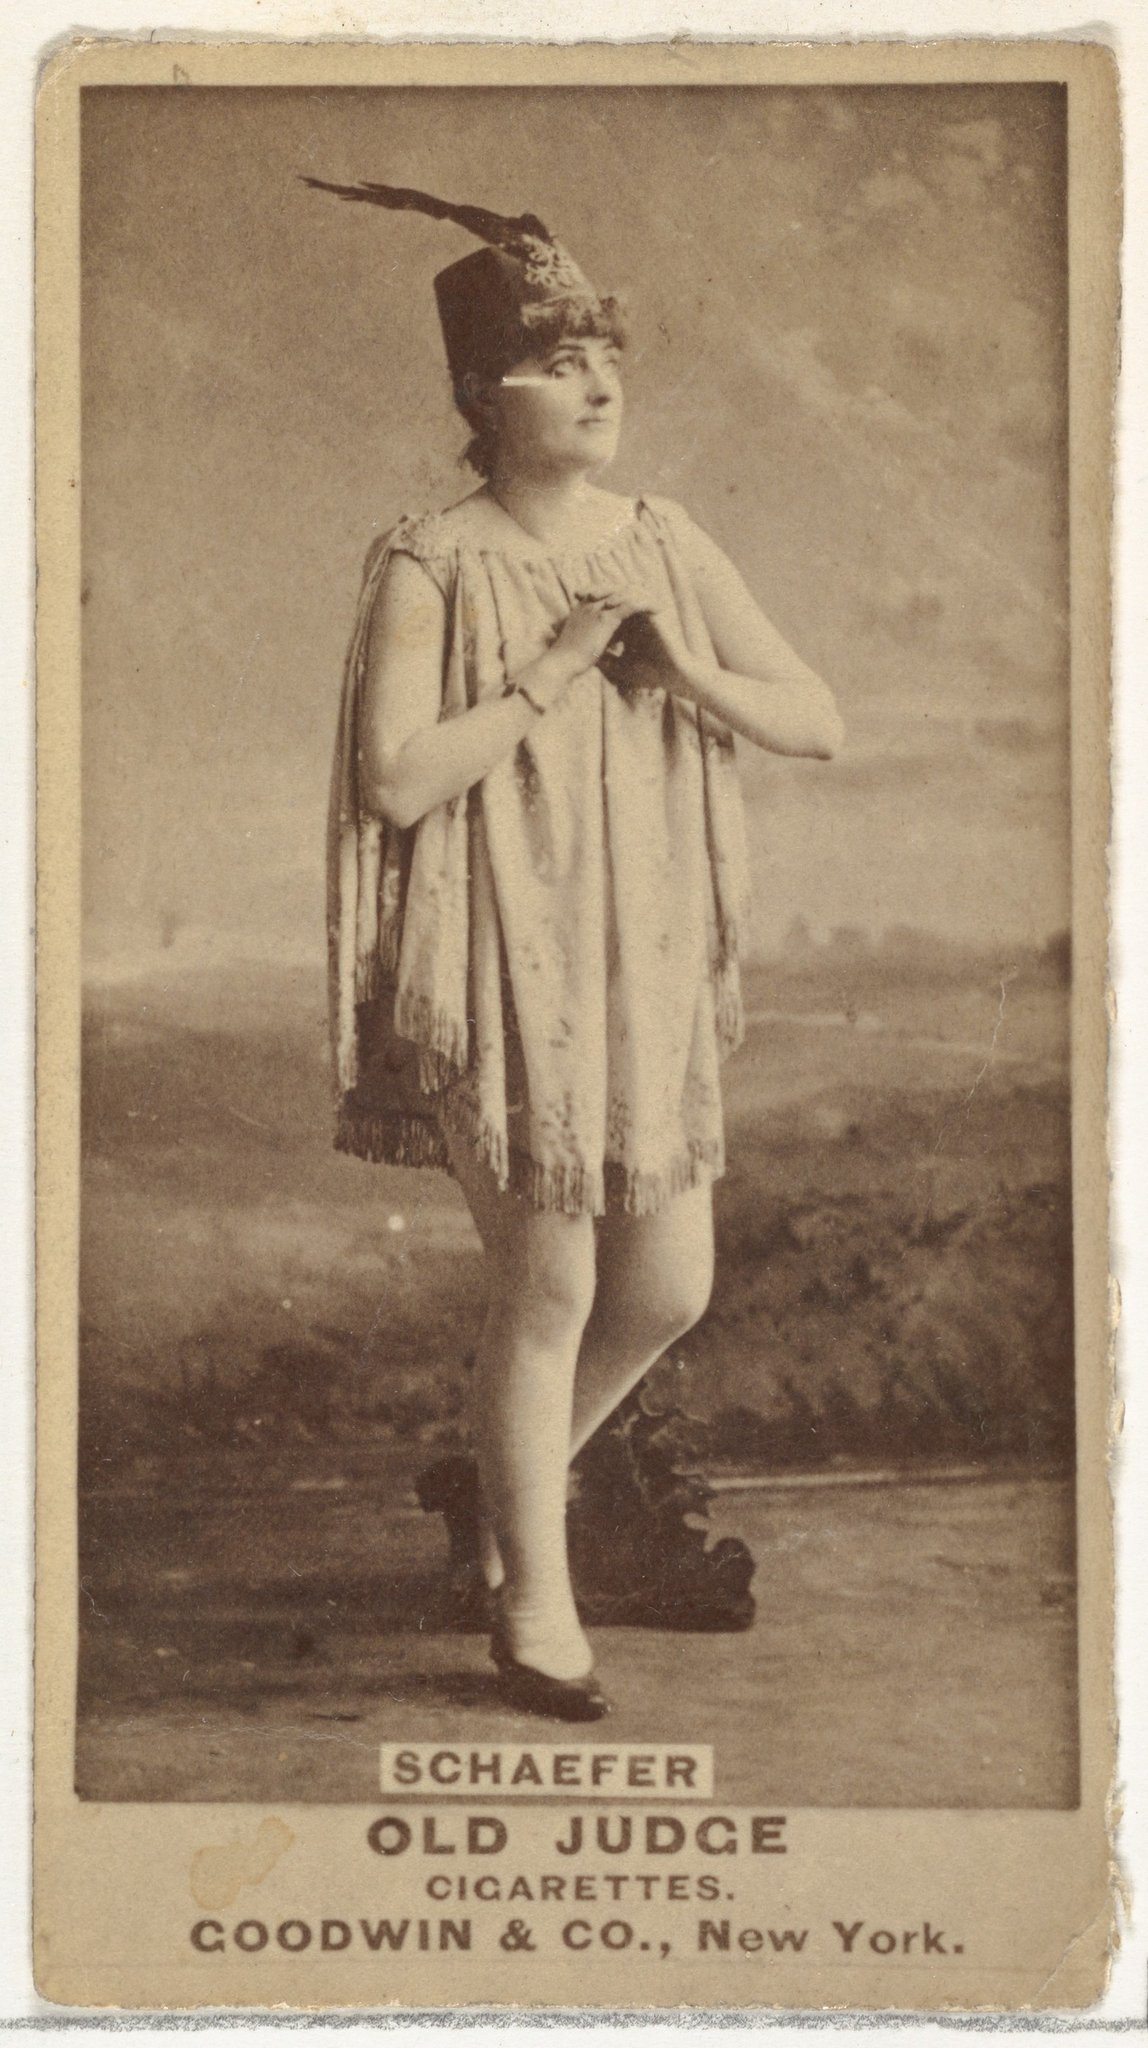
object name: photograph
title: Schaefer, from the Actors and Actresses series (N171) for Old Judge Cigarettes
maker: goodwin & company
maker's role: publisher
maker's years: 1850-1950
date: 1886-1890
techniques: albumen silver print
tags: portraits,women,actresses